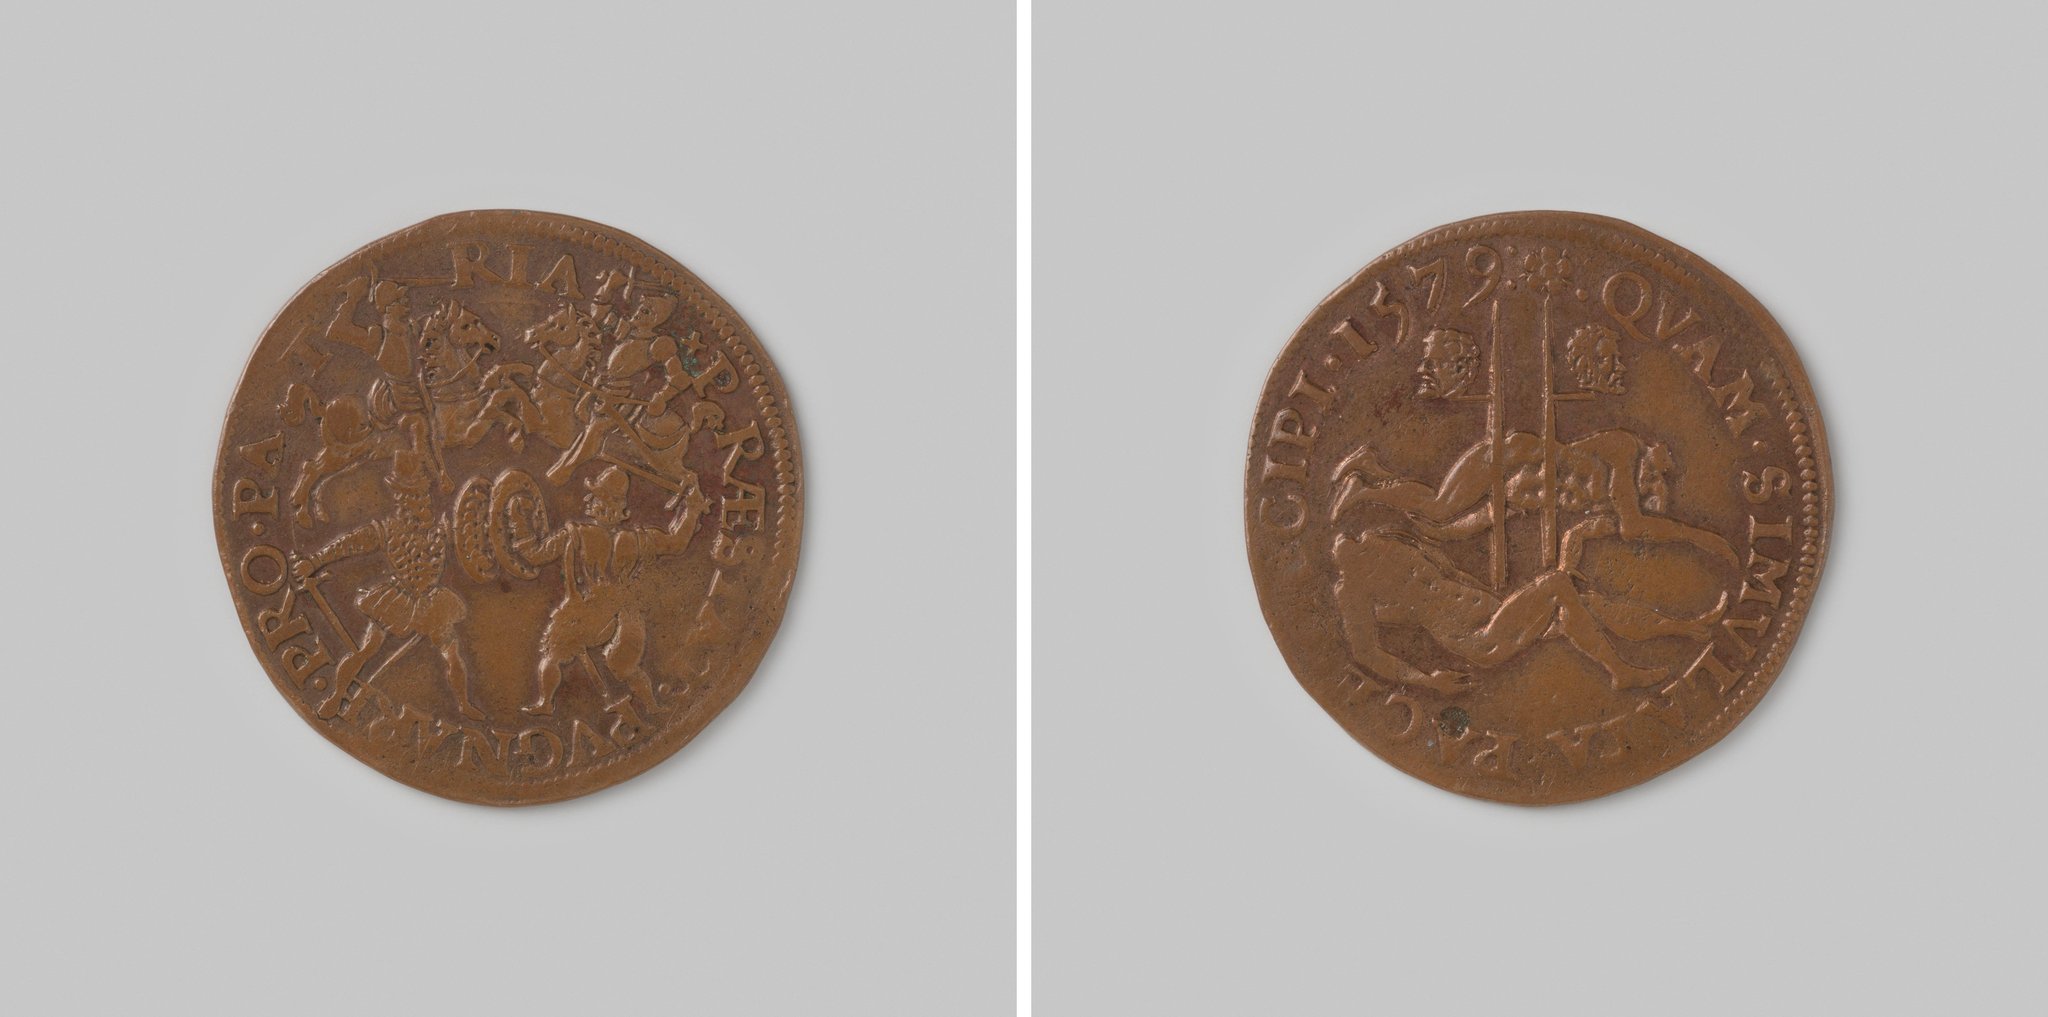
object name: jeton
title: Rekenpenning uit Dordrecht op de onthoofding van Egmont en Horne en op de voortzetting van de strijd 1579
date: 1579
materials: copper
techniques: striking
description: Koperen penning, op de voorzijde twee ruiters en twee voetknechten in gevecht, met omschrift, op de keerzijde de lichamen van Egmont en Horne, hun hoofden op staken, met omschrift.